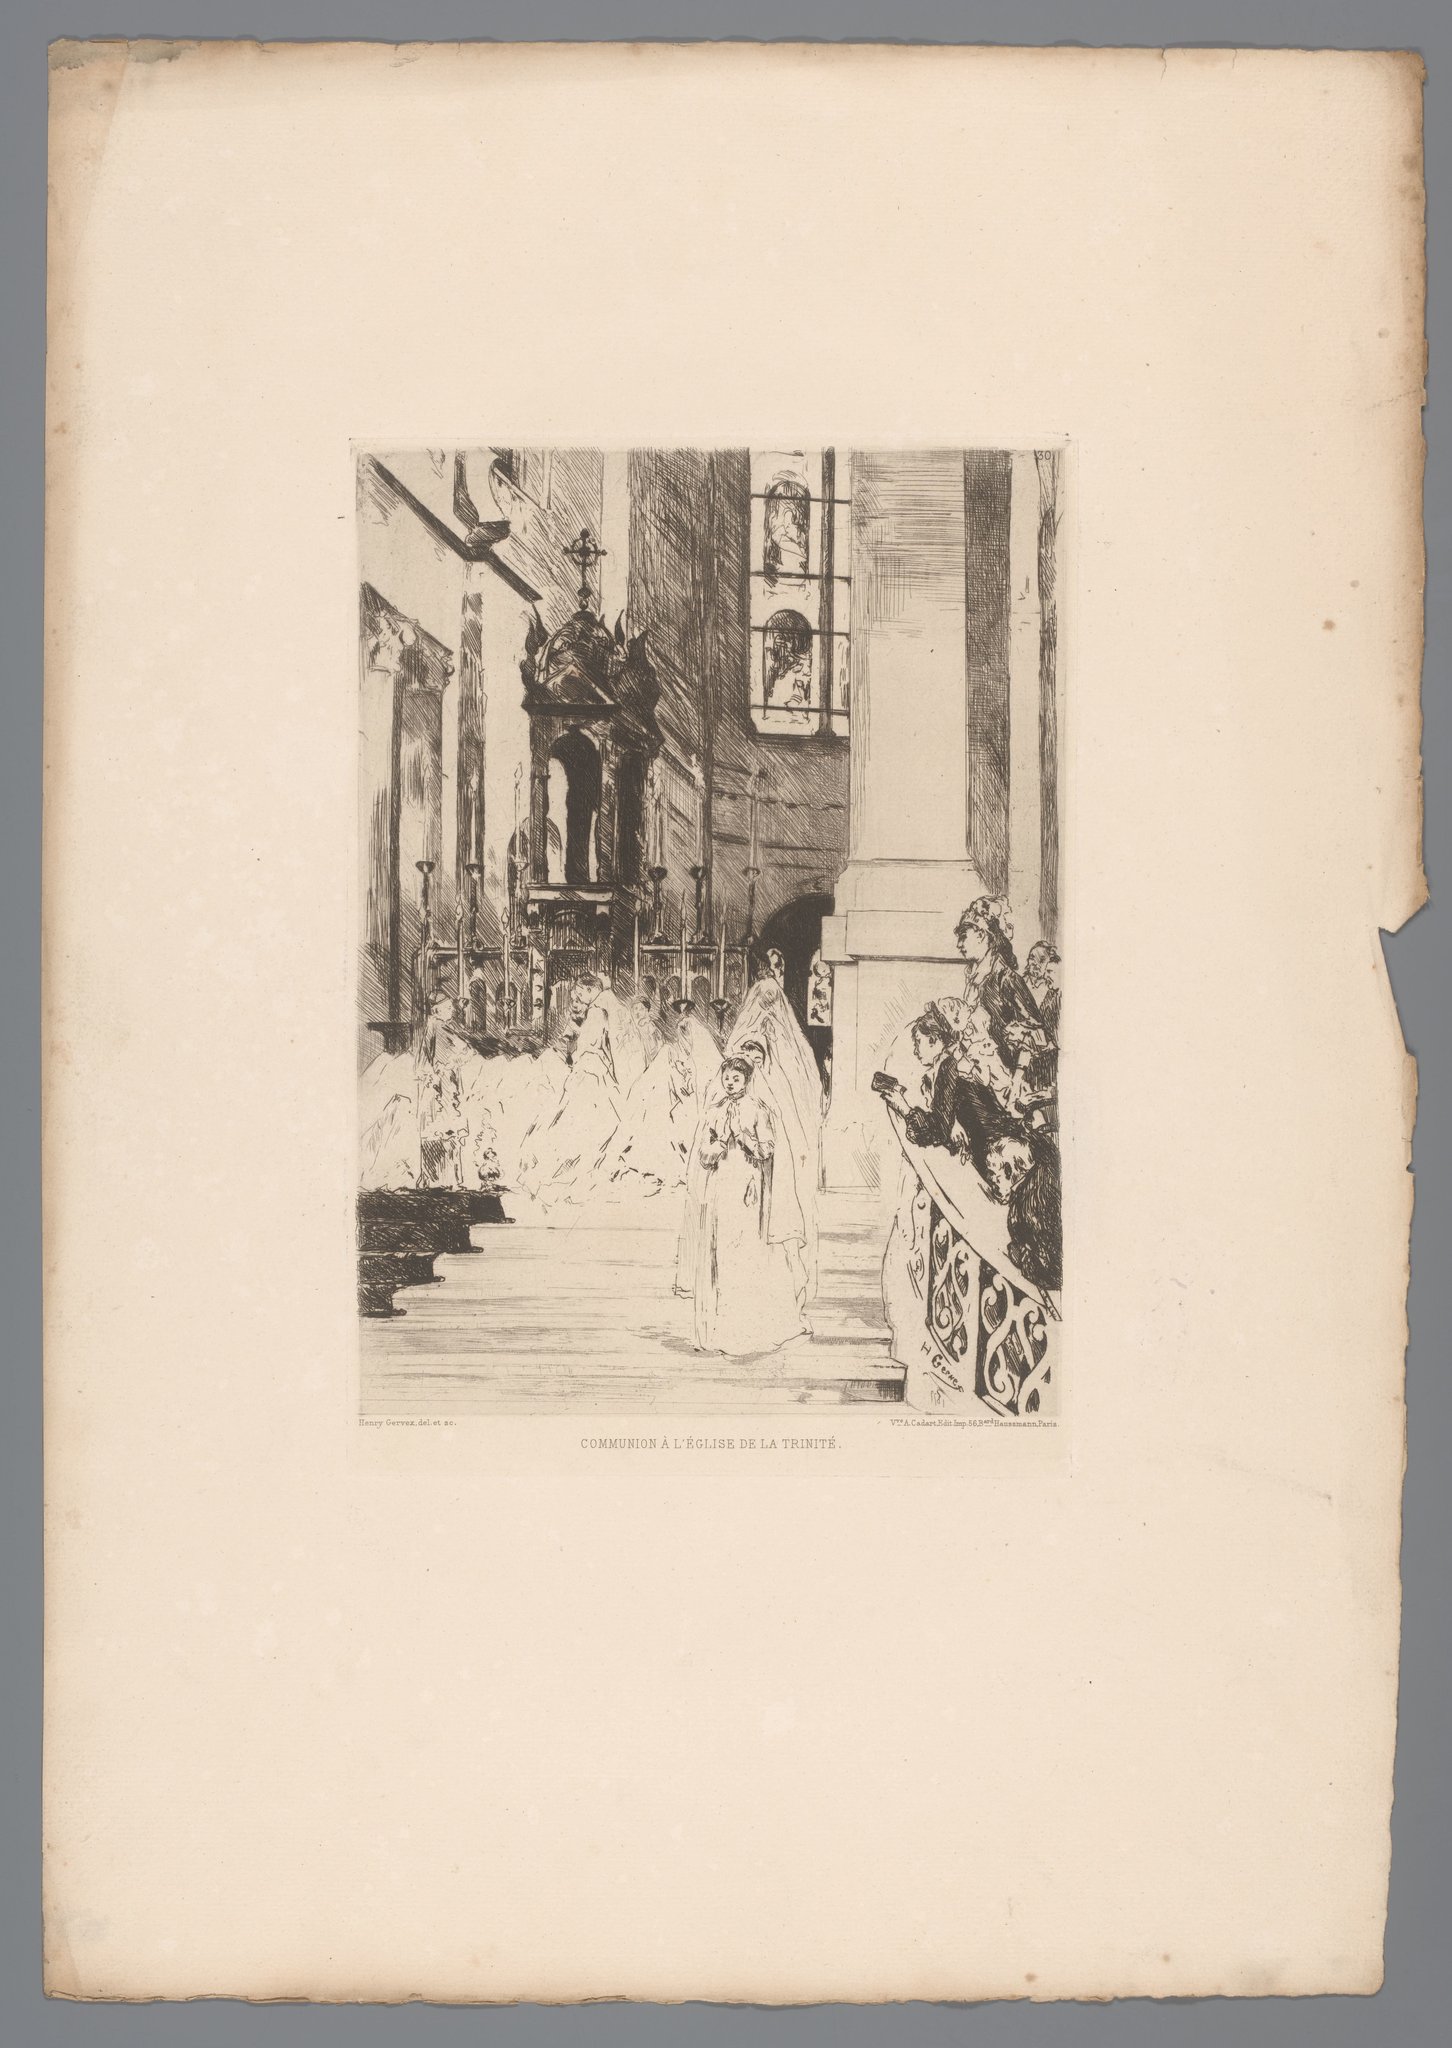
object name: print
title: L'eau-forte en 1878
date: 1878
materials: paper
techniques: drypoint, etching, intaglio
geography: paris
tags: first communion, interior of church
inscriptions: collector's mark: Lugt 2760, watermark, collector's mark: ‘AFE v S’, collector's mark: Lugt 2228